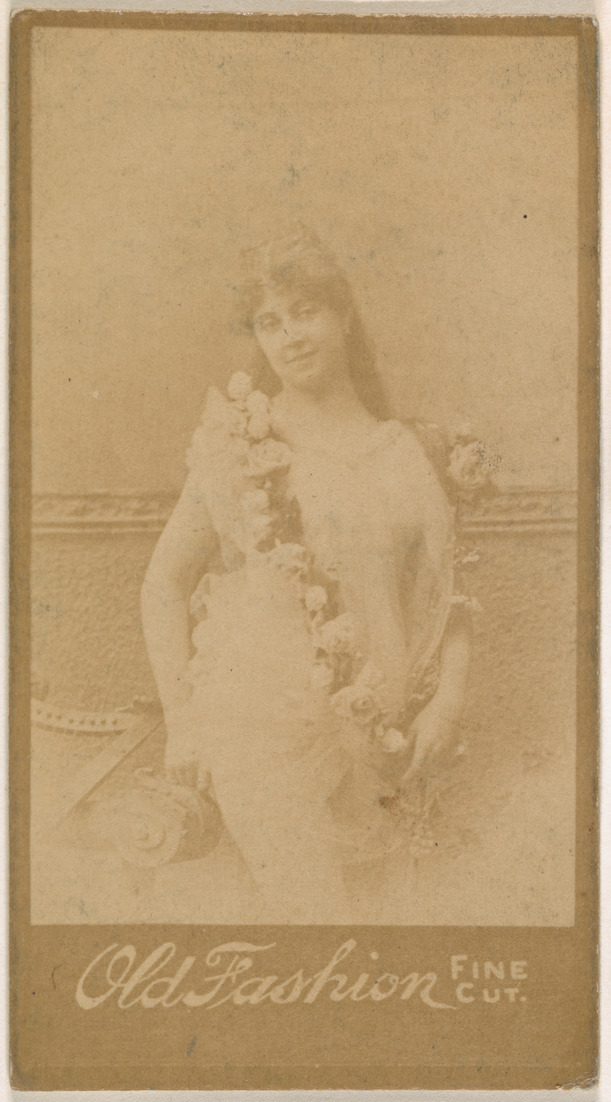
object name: photograph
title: Actress wearing floral sash, from the Actresses series (N664) promoting Old Fashion Fine Cut Tobacco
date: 1888-1890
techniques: albumen silver print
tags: portraits,women,actresses